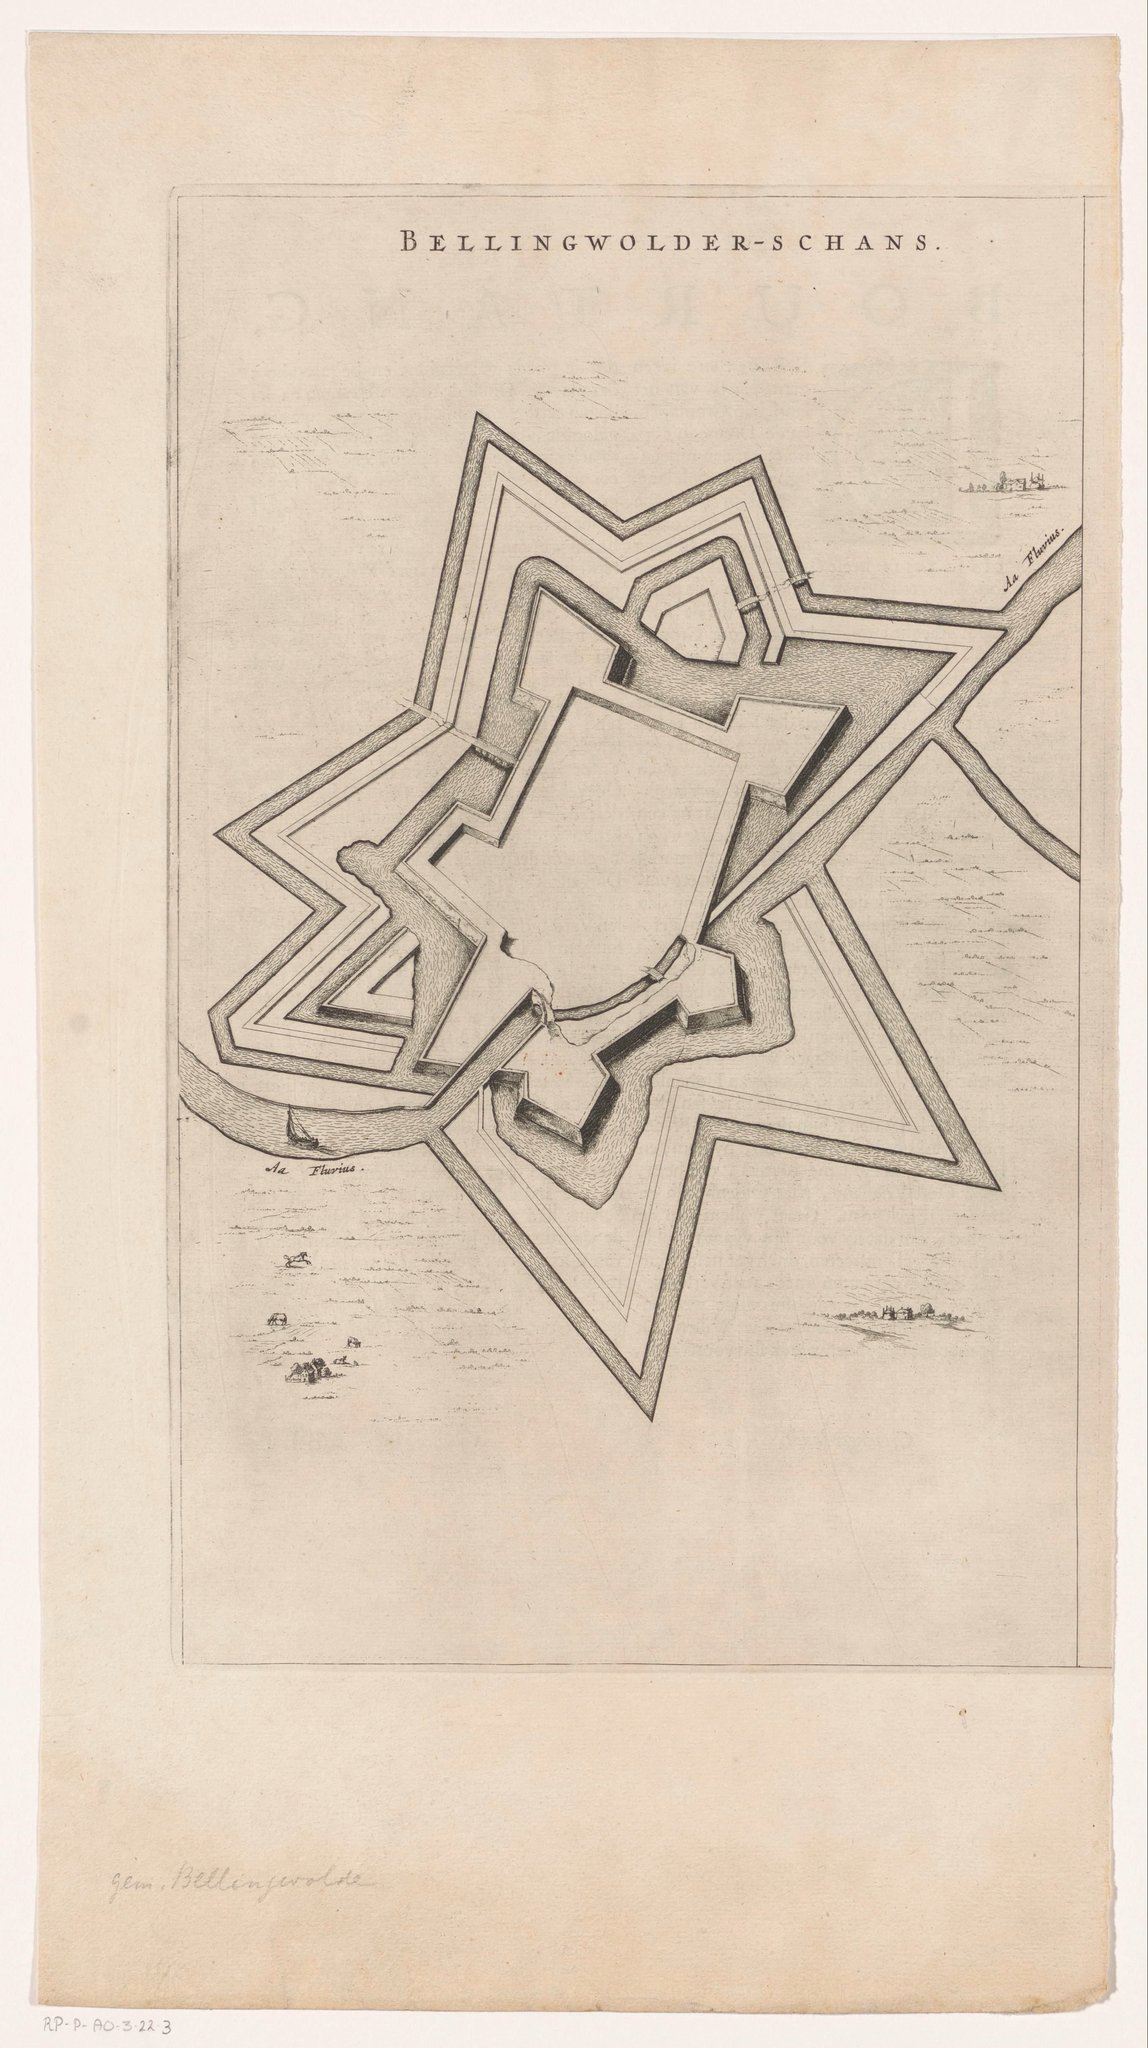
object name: print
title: Bellingwolder-schans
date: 1652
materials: paper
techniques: engraving, etching, letterpress printing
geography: amsterdam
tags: fortress, maps of cities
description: Prent gebruikt in: Blaeu, Johannes Willemszoon. Toonneel der steden van de Vereenighde Nederlanden. 2 delen. Amsterdam: Johannes Willemszoon Blaeu, 1652, dl. 1.